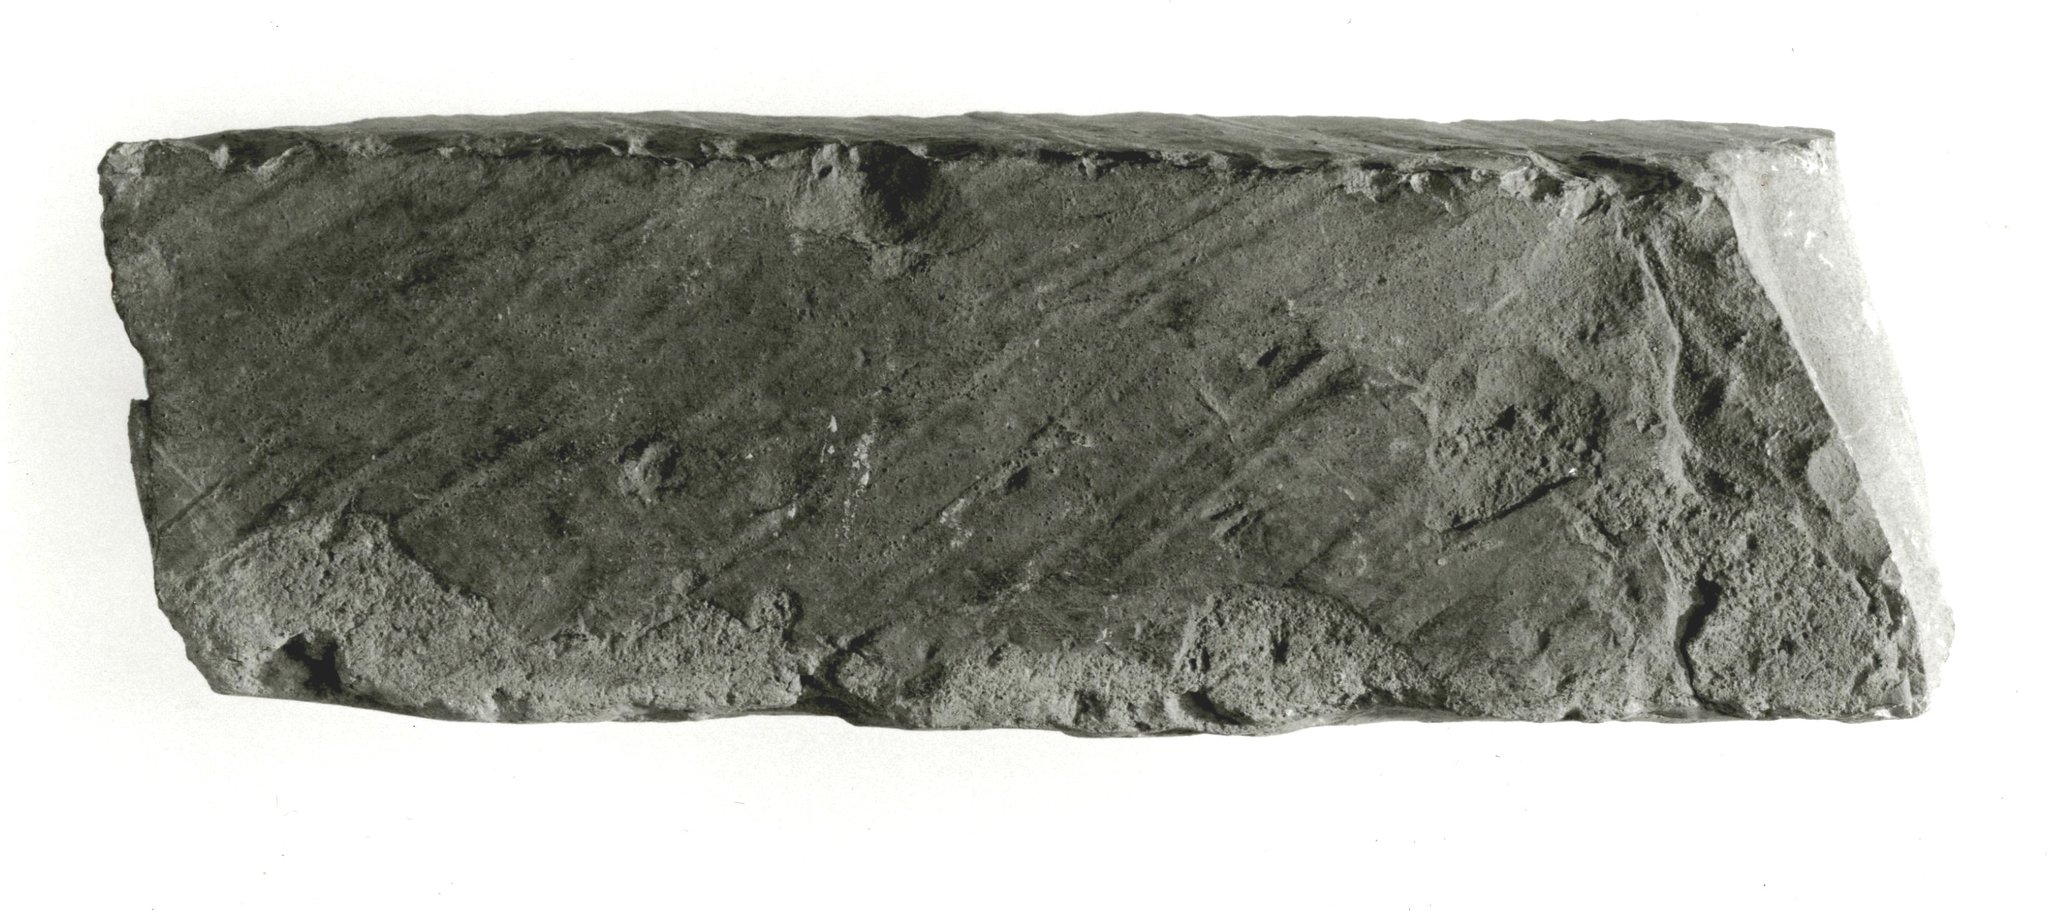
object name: relief, tomb of nespekashuty, wall casing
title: Wall casing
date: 664-610 BCE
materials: limestone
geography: egypt